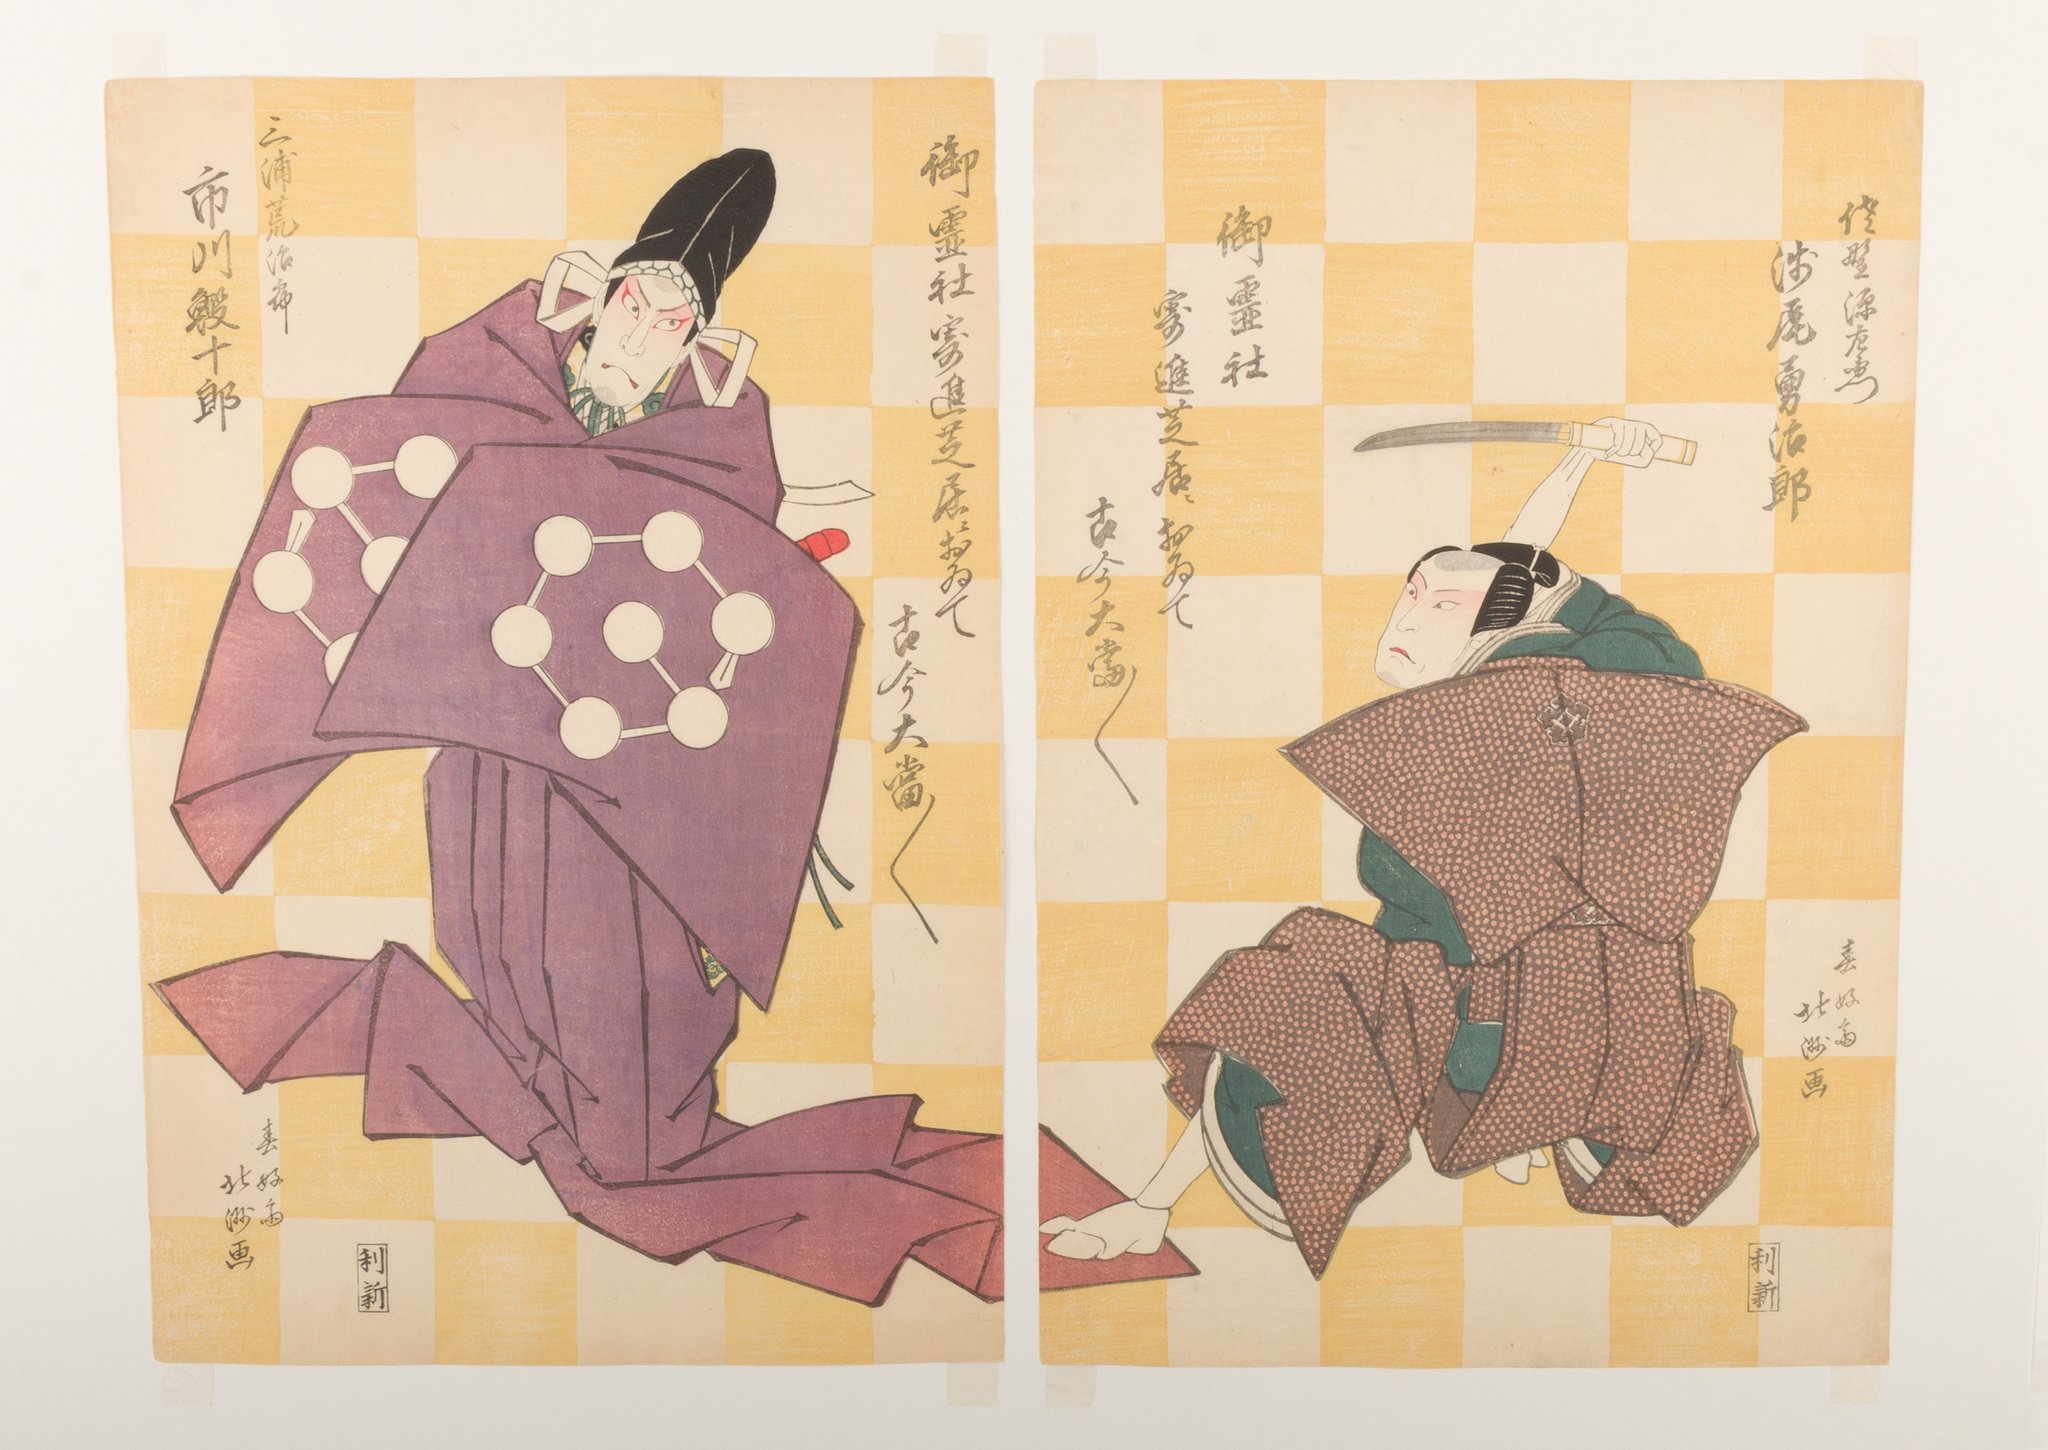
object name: woodblock print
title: Kabuki Actors Asao Yūjirō as Sano Genzaemon and Ichikawa Ebijūrō I as Miura Arajirō, in the play Keisei Sano no Funabashi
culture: japanese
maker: shunkōsai hokushū 春好斎北洲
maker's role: artist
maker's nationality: japanese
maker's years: 1808-1832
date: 1822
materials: ink, paper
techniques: woodblock print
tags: knives,men,actors